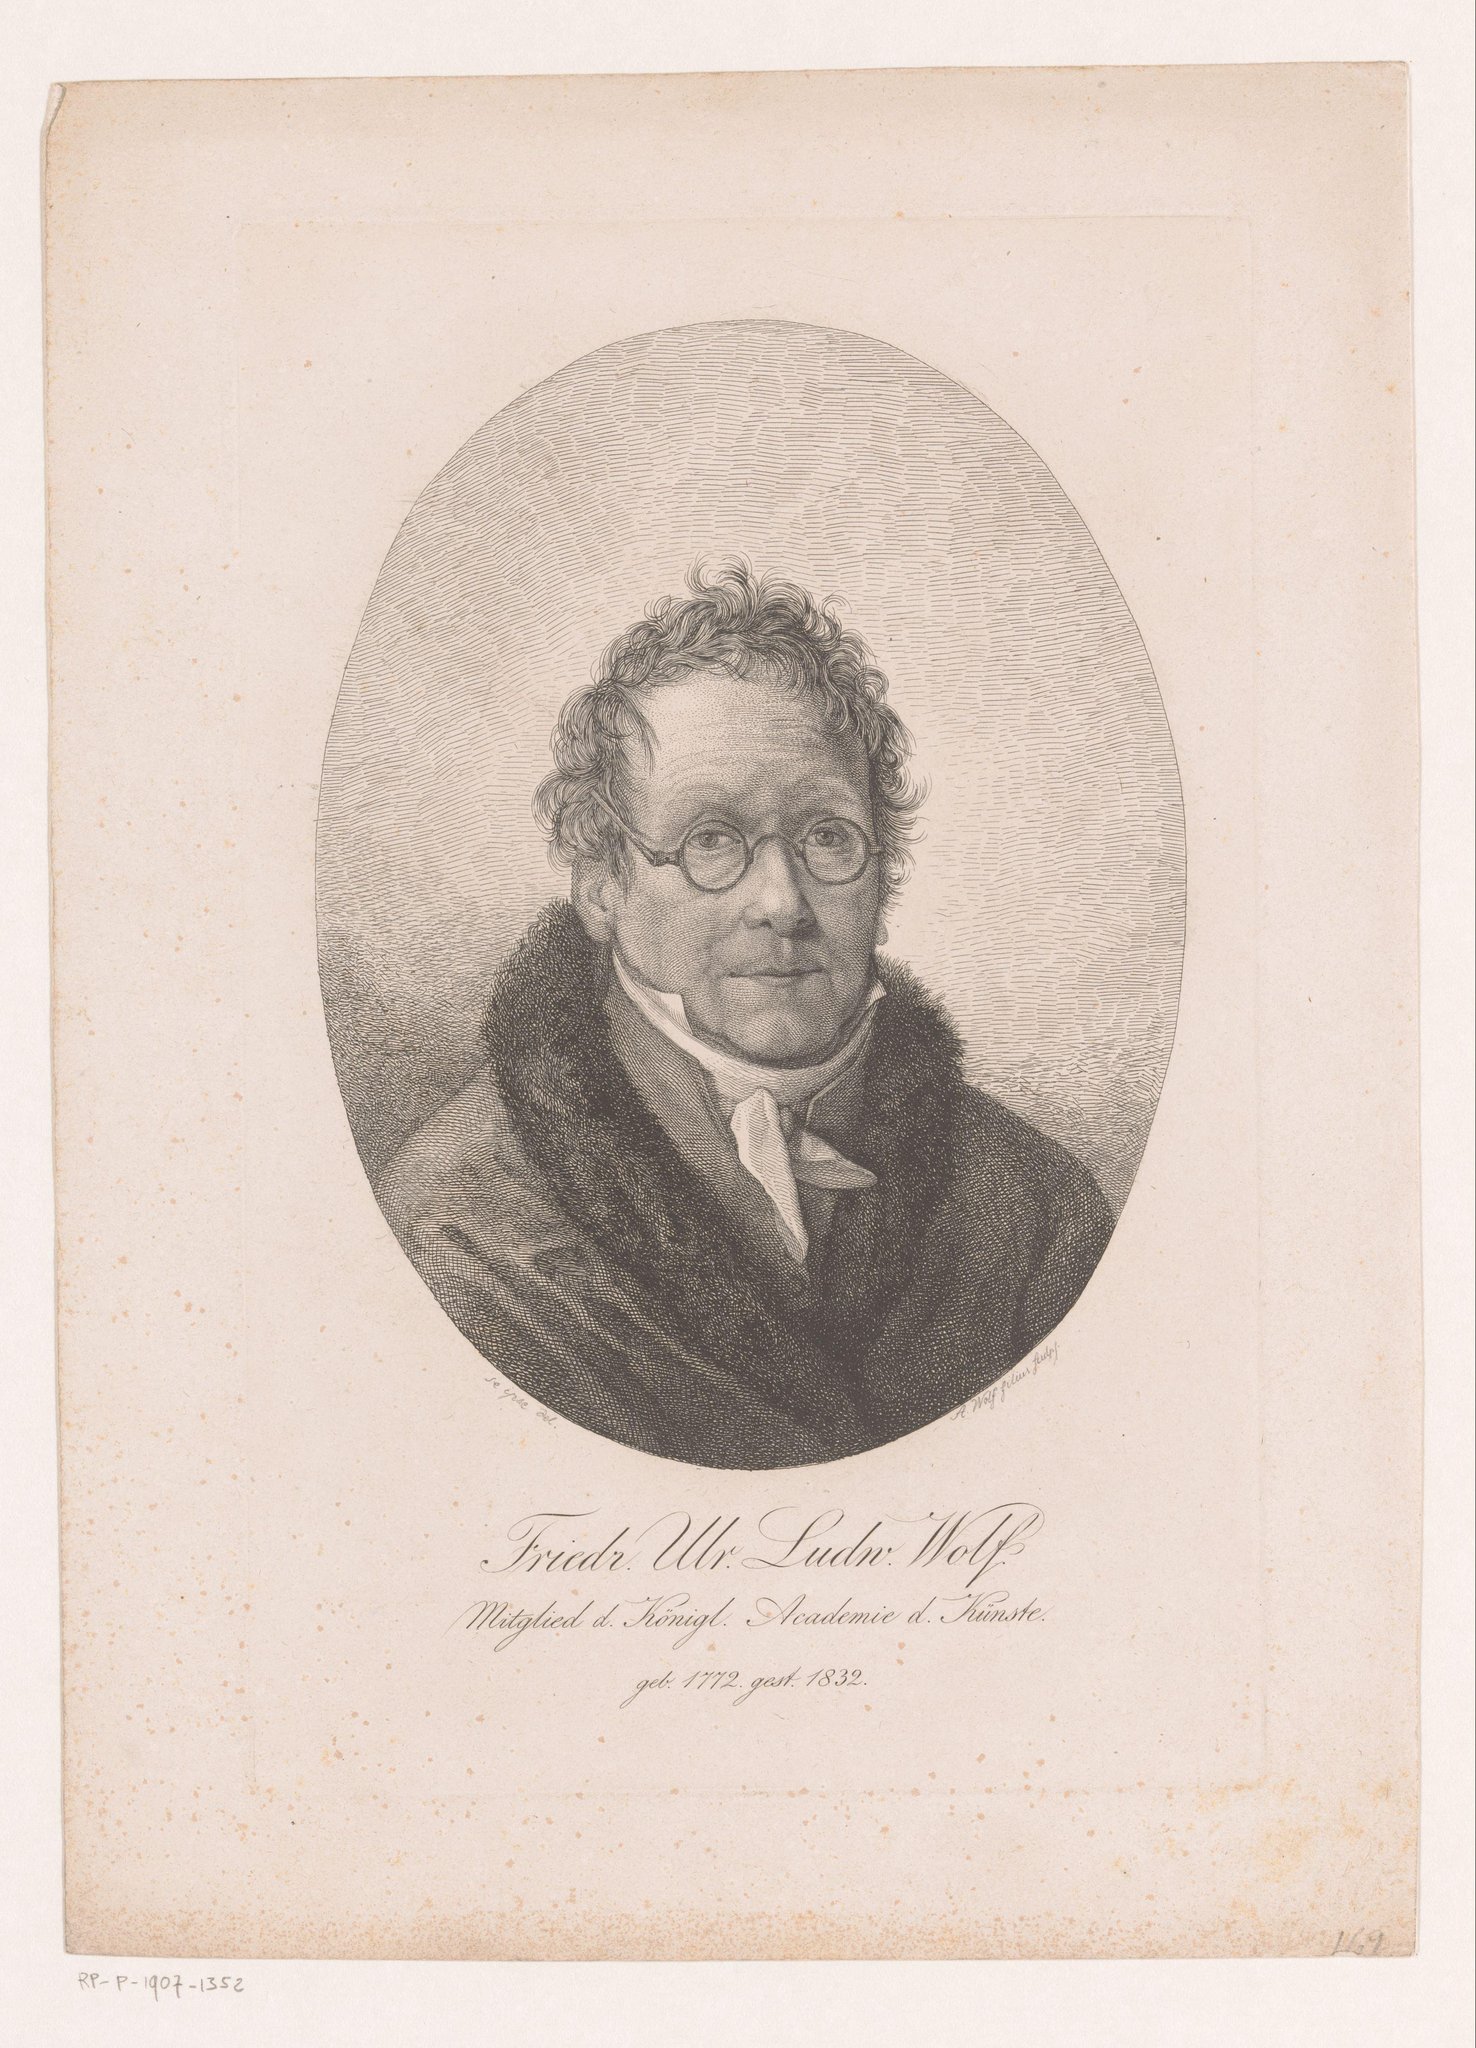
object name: print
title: Portret van Ulrich Ludwig Friedrich Wolf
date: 1821-1835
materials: paper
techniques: etching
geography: germany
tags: berlin, painter, print maker, draughtsman, ludwig wolf, historical persons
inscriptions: collector's mark: Lugt 2228